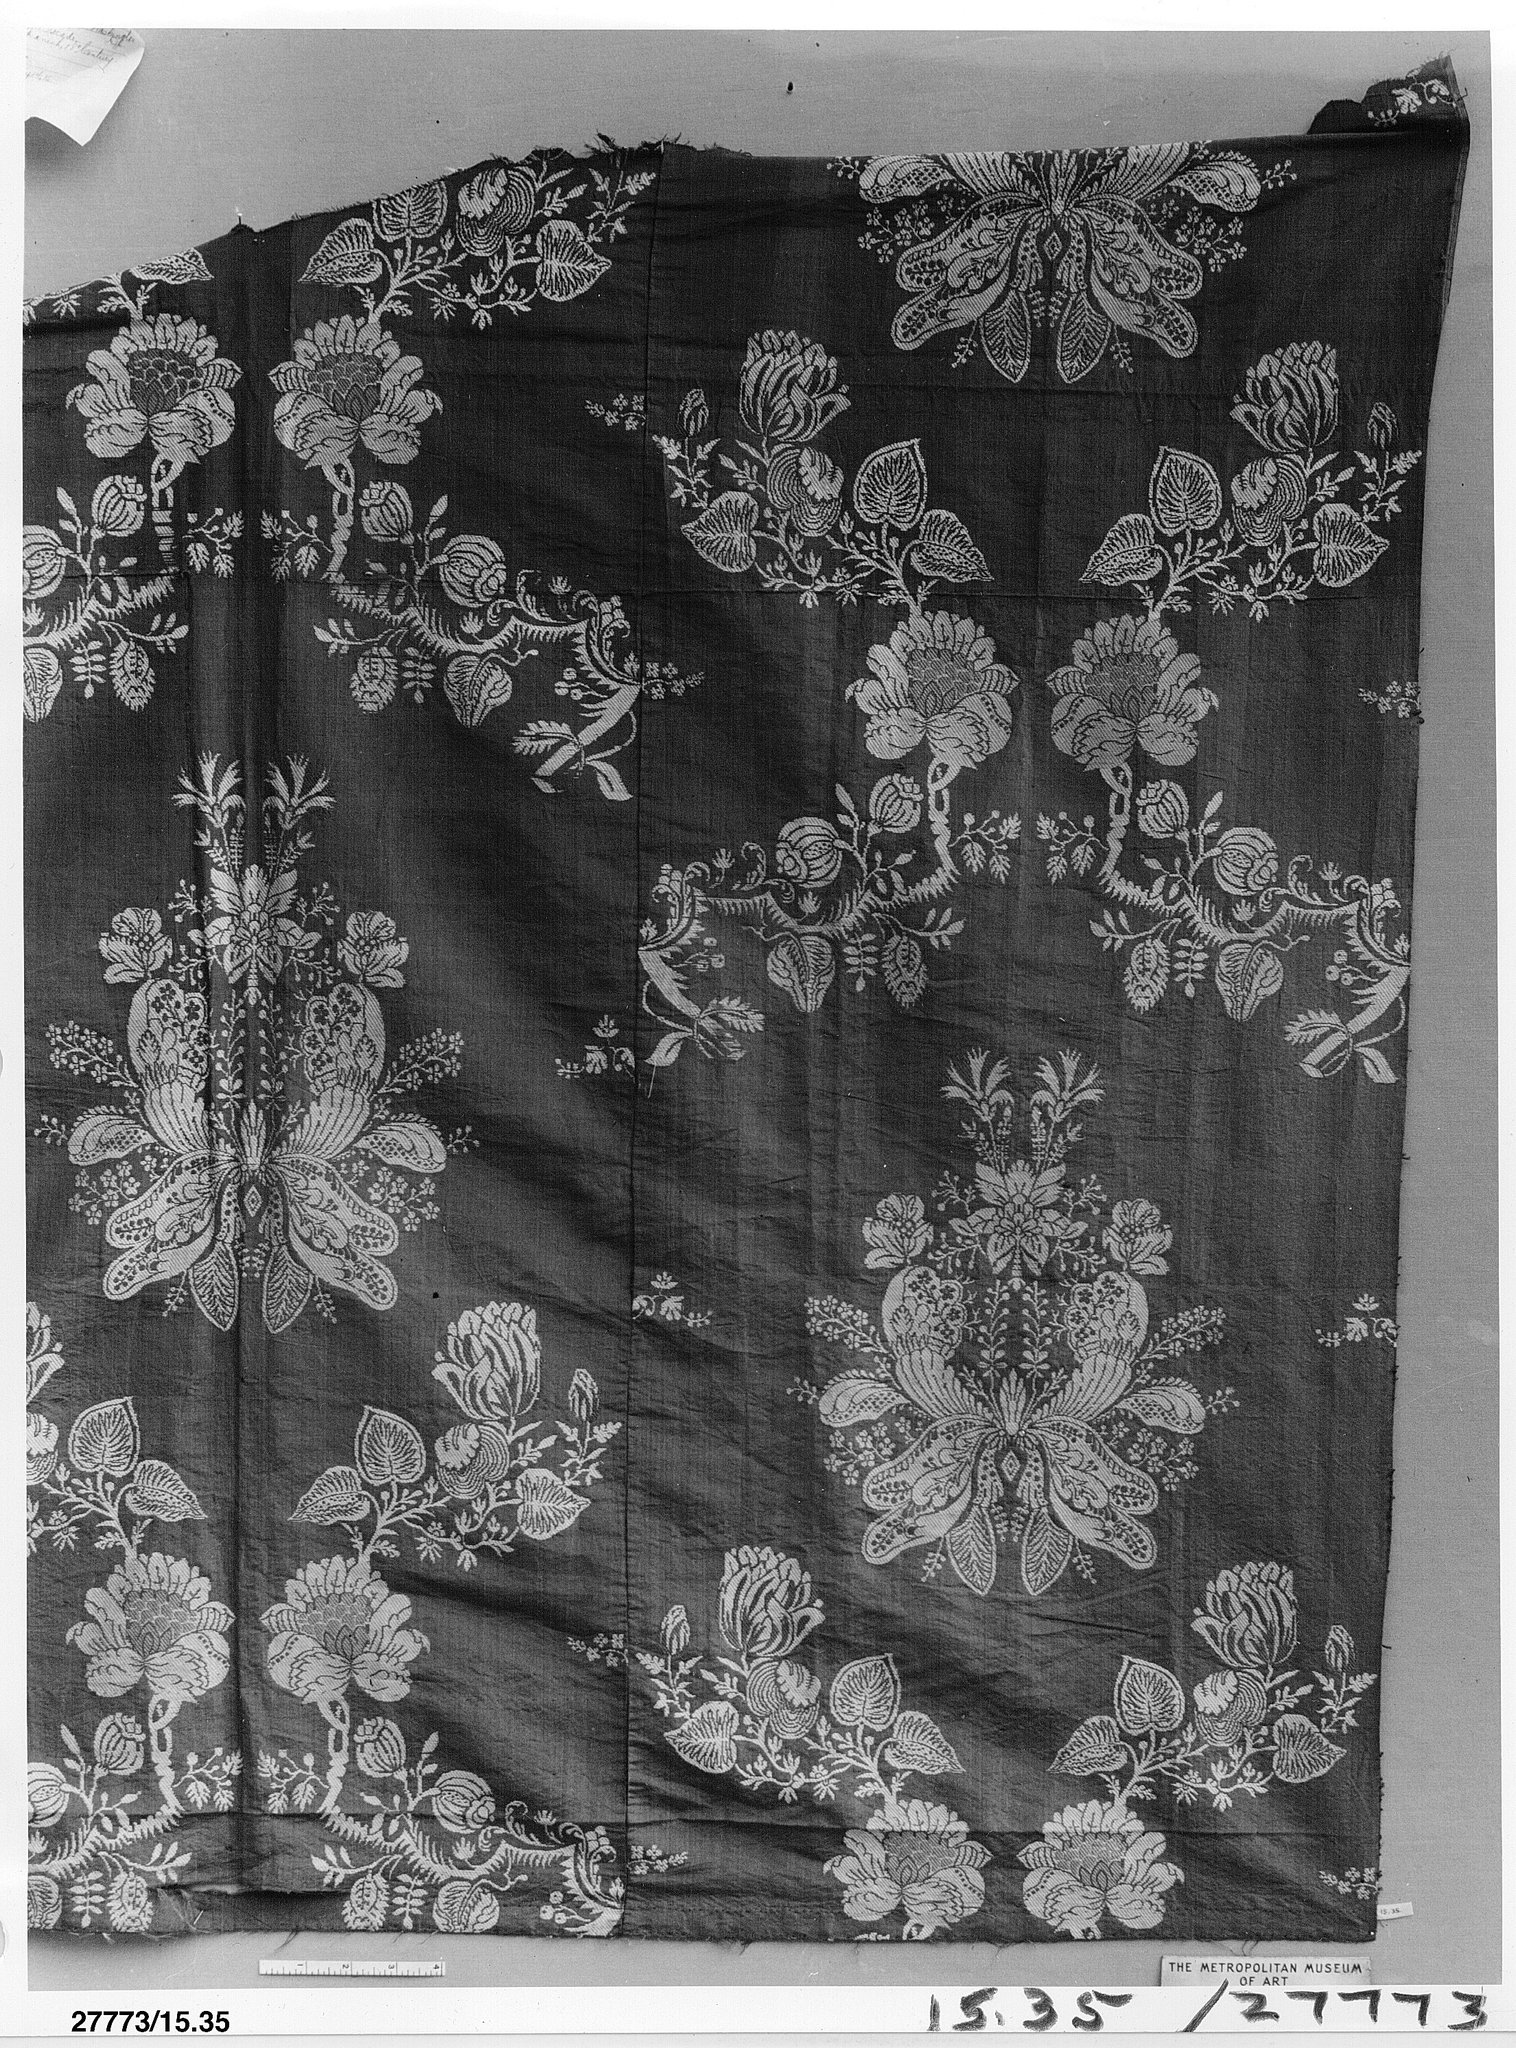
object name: piece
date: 1734-1766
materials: silk